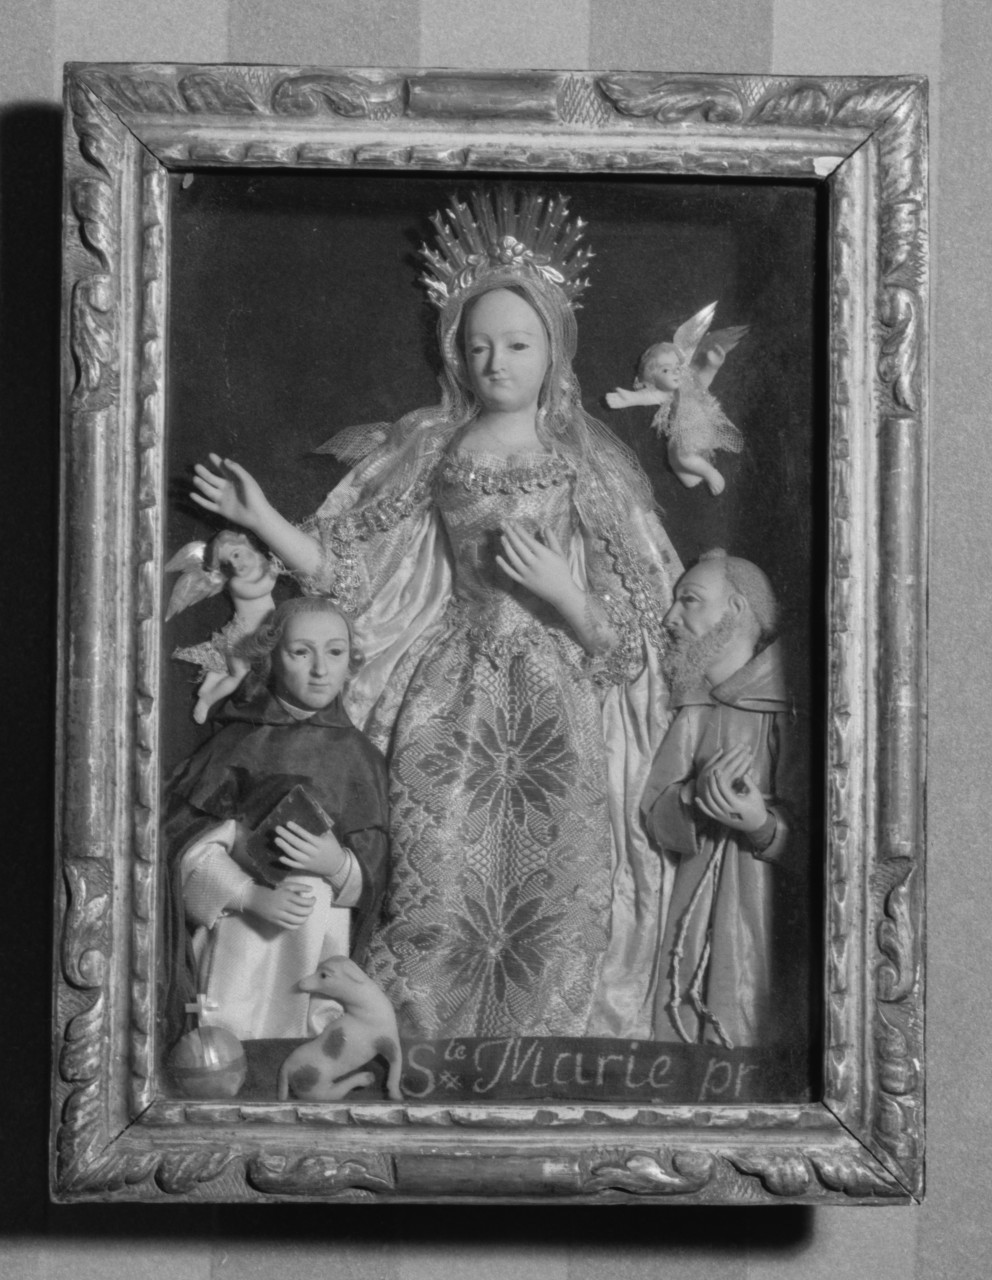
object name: sculpture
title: The Virgin Mary between St. Dominic and St. Francis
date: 1701-1800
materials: glass, hair, silk, wax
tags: dogs,angels,virgin mary,saints